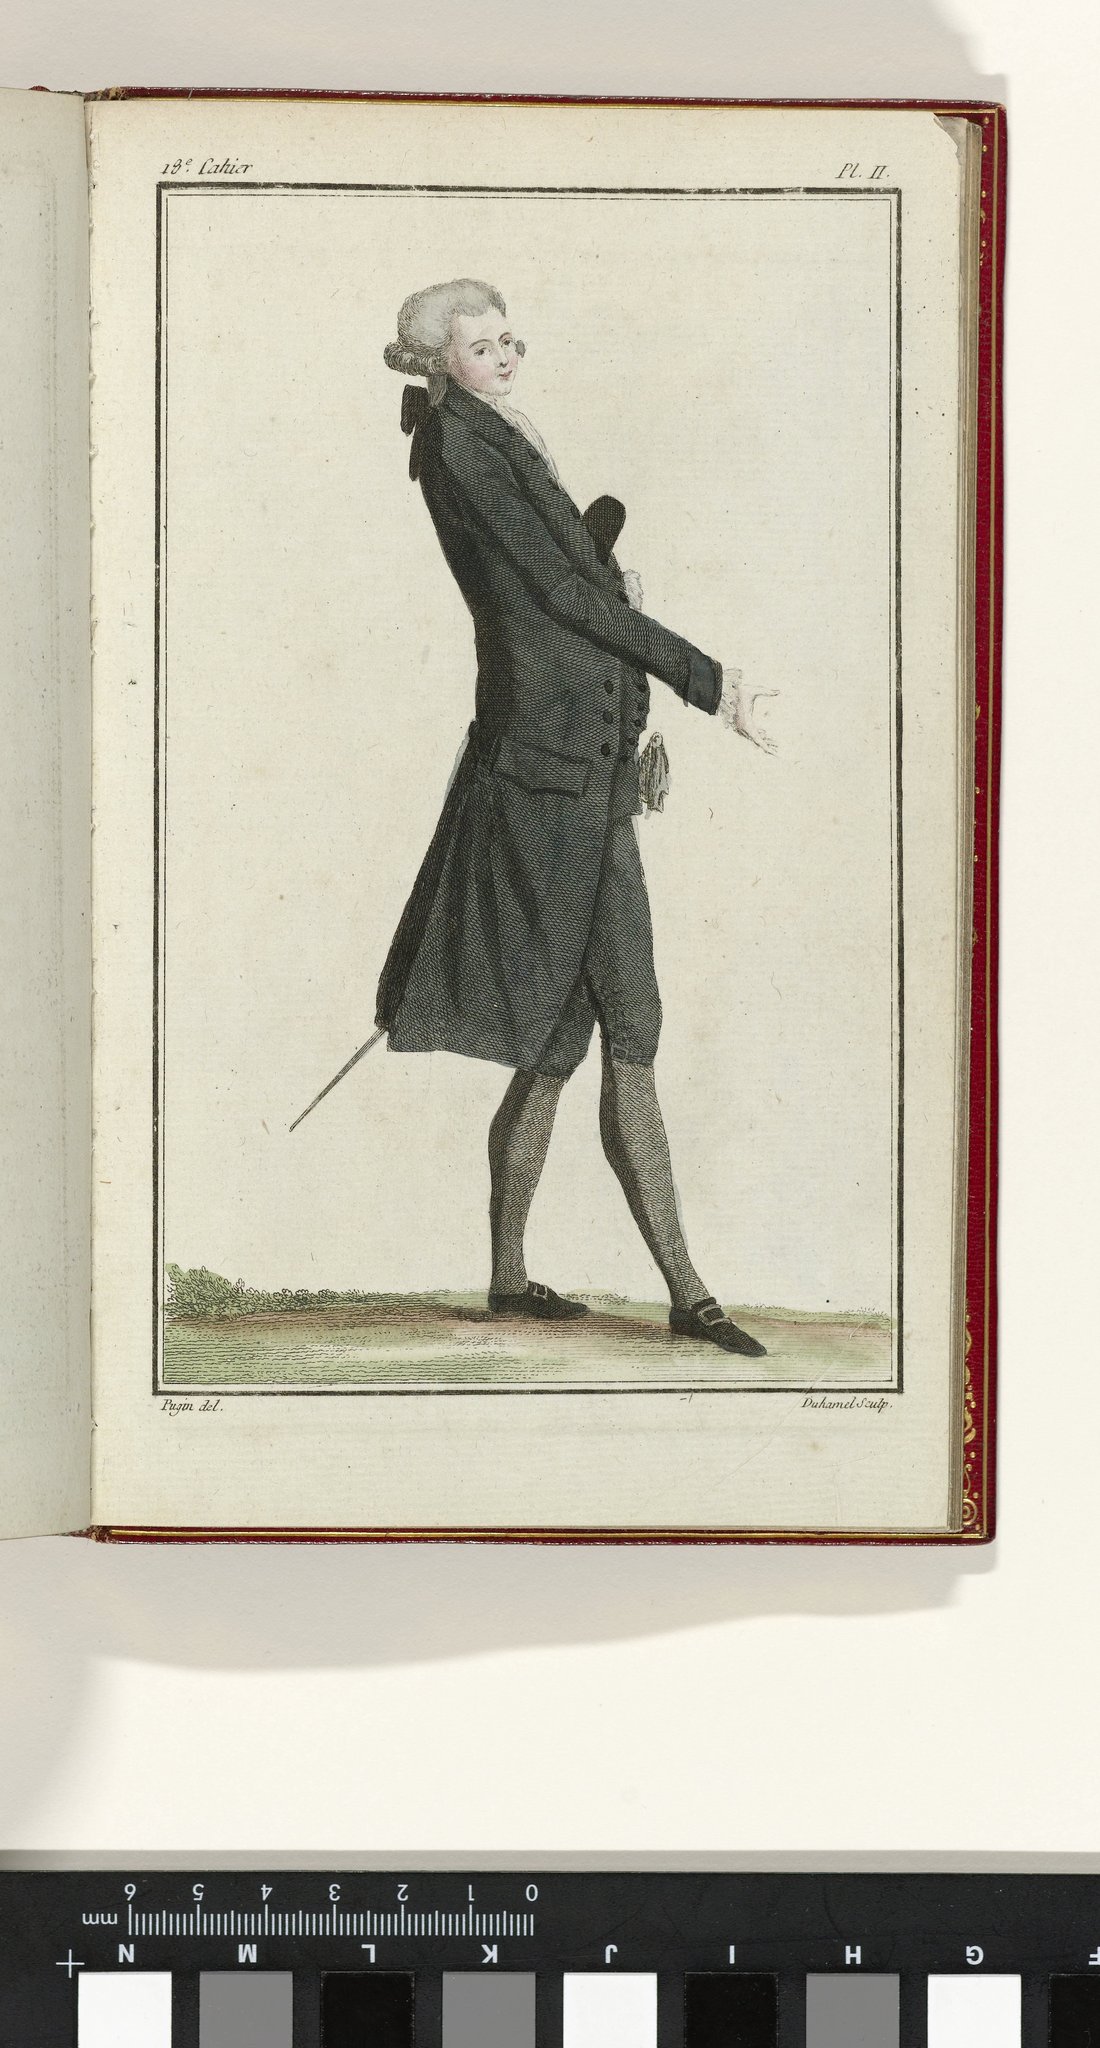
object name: fashion print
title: Cabinet des Modes ou les Modes Nouvelles, 1 Aout 1786, pl. II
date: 1786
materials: paper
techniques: engraving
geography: paris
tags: clothing for the upper part of the body (vest) (+ men's clothes), coat (+ men's clothes), head-gear: hat (+ men's clothes), styles of hairdress, fashion plates, mourning dress, neck-gear: collar (+ men's clothes)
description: Man in zware rouw. Volgens de begeleidende tekst draagt hij een habit van laken, zonder knopen op de oplegsels en zakken, (rouwkostuum voor de zomer) met zes knopen op de voorpanden. Aan zijn linkerzij een degen, versierd met een zwarte crêpe. Schoenen van castor. De gespen op de kousenbanden en de schoenen zijn van brons. Een lange das (cravate) valt over de jabot van het hemd. Manchetten en jabot zijn van batist. Onder de arm een grote hoed, gegarneerd met zwarte crêpe. De prent maakt deel uit van het 18e Cahier uit Cabinet des Modes ou les Modes Nouvelles. De serie bestaat uit 72 modeprenten, uitgegeven door Buisson, Parijs, 15 november 1785 - 1 november 1786.